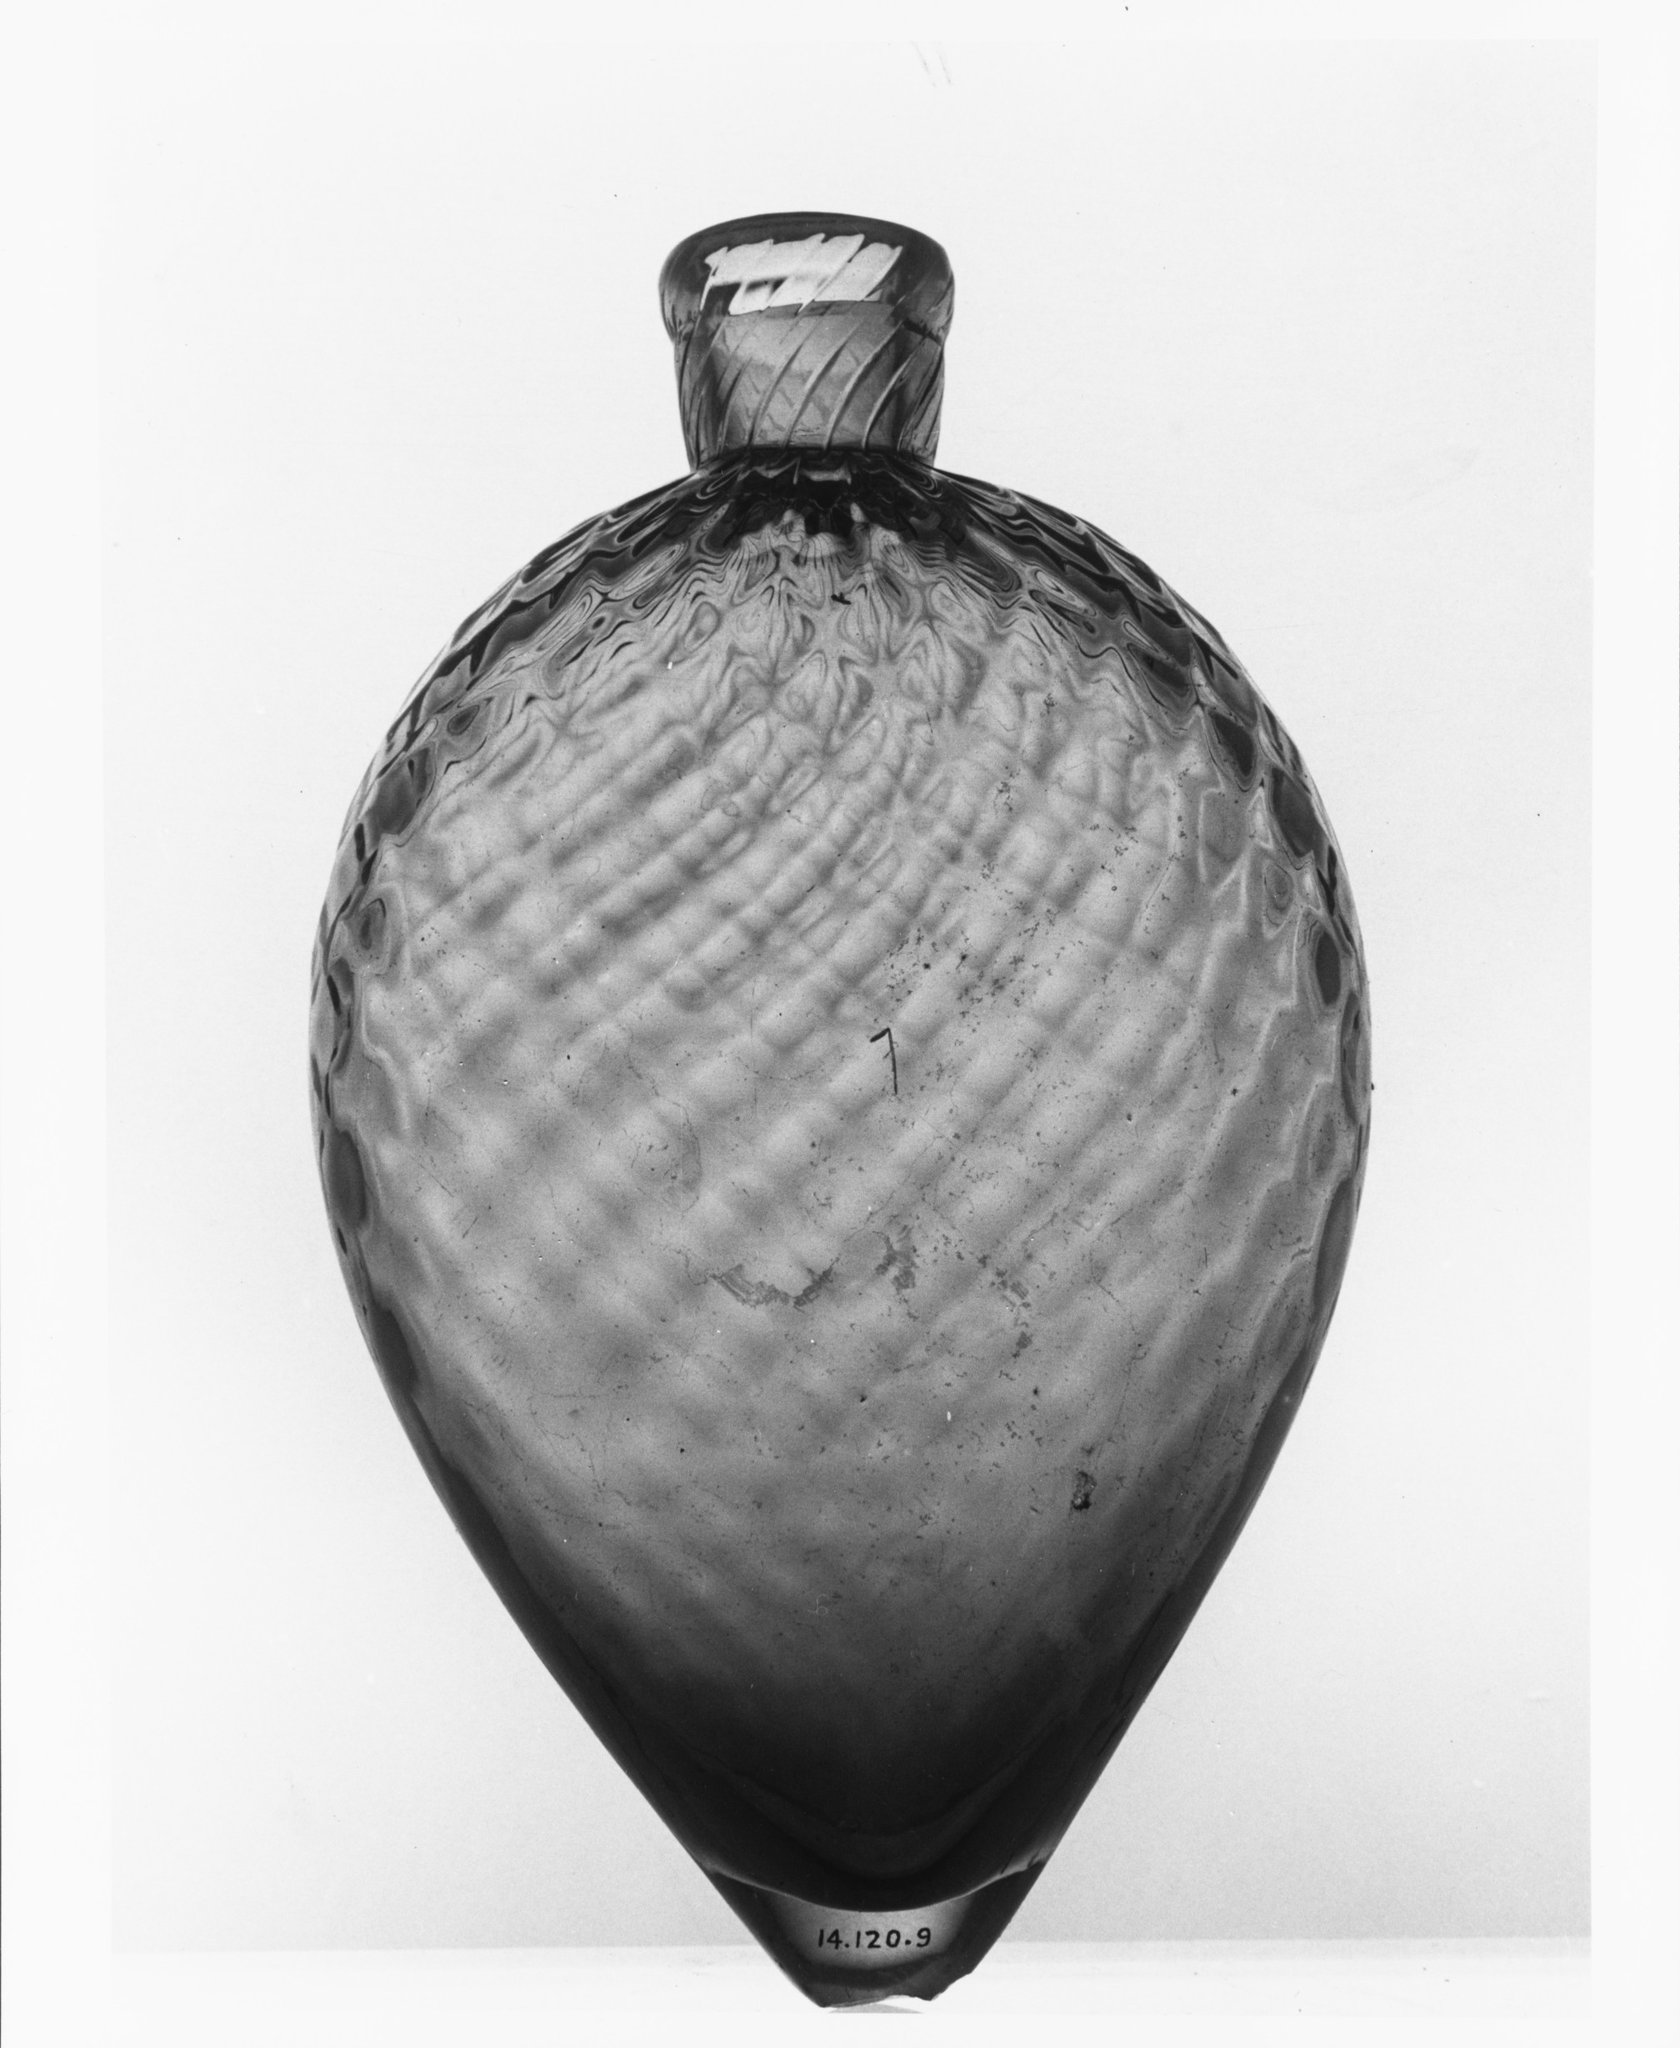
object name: flask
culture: european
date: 1850-1900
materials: glass, lead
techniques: glassblowing, molding